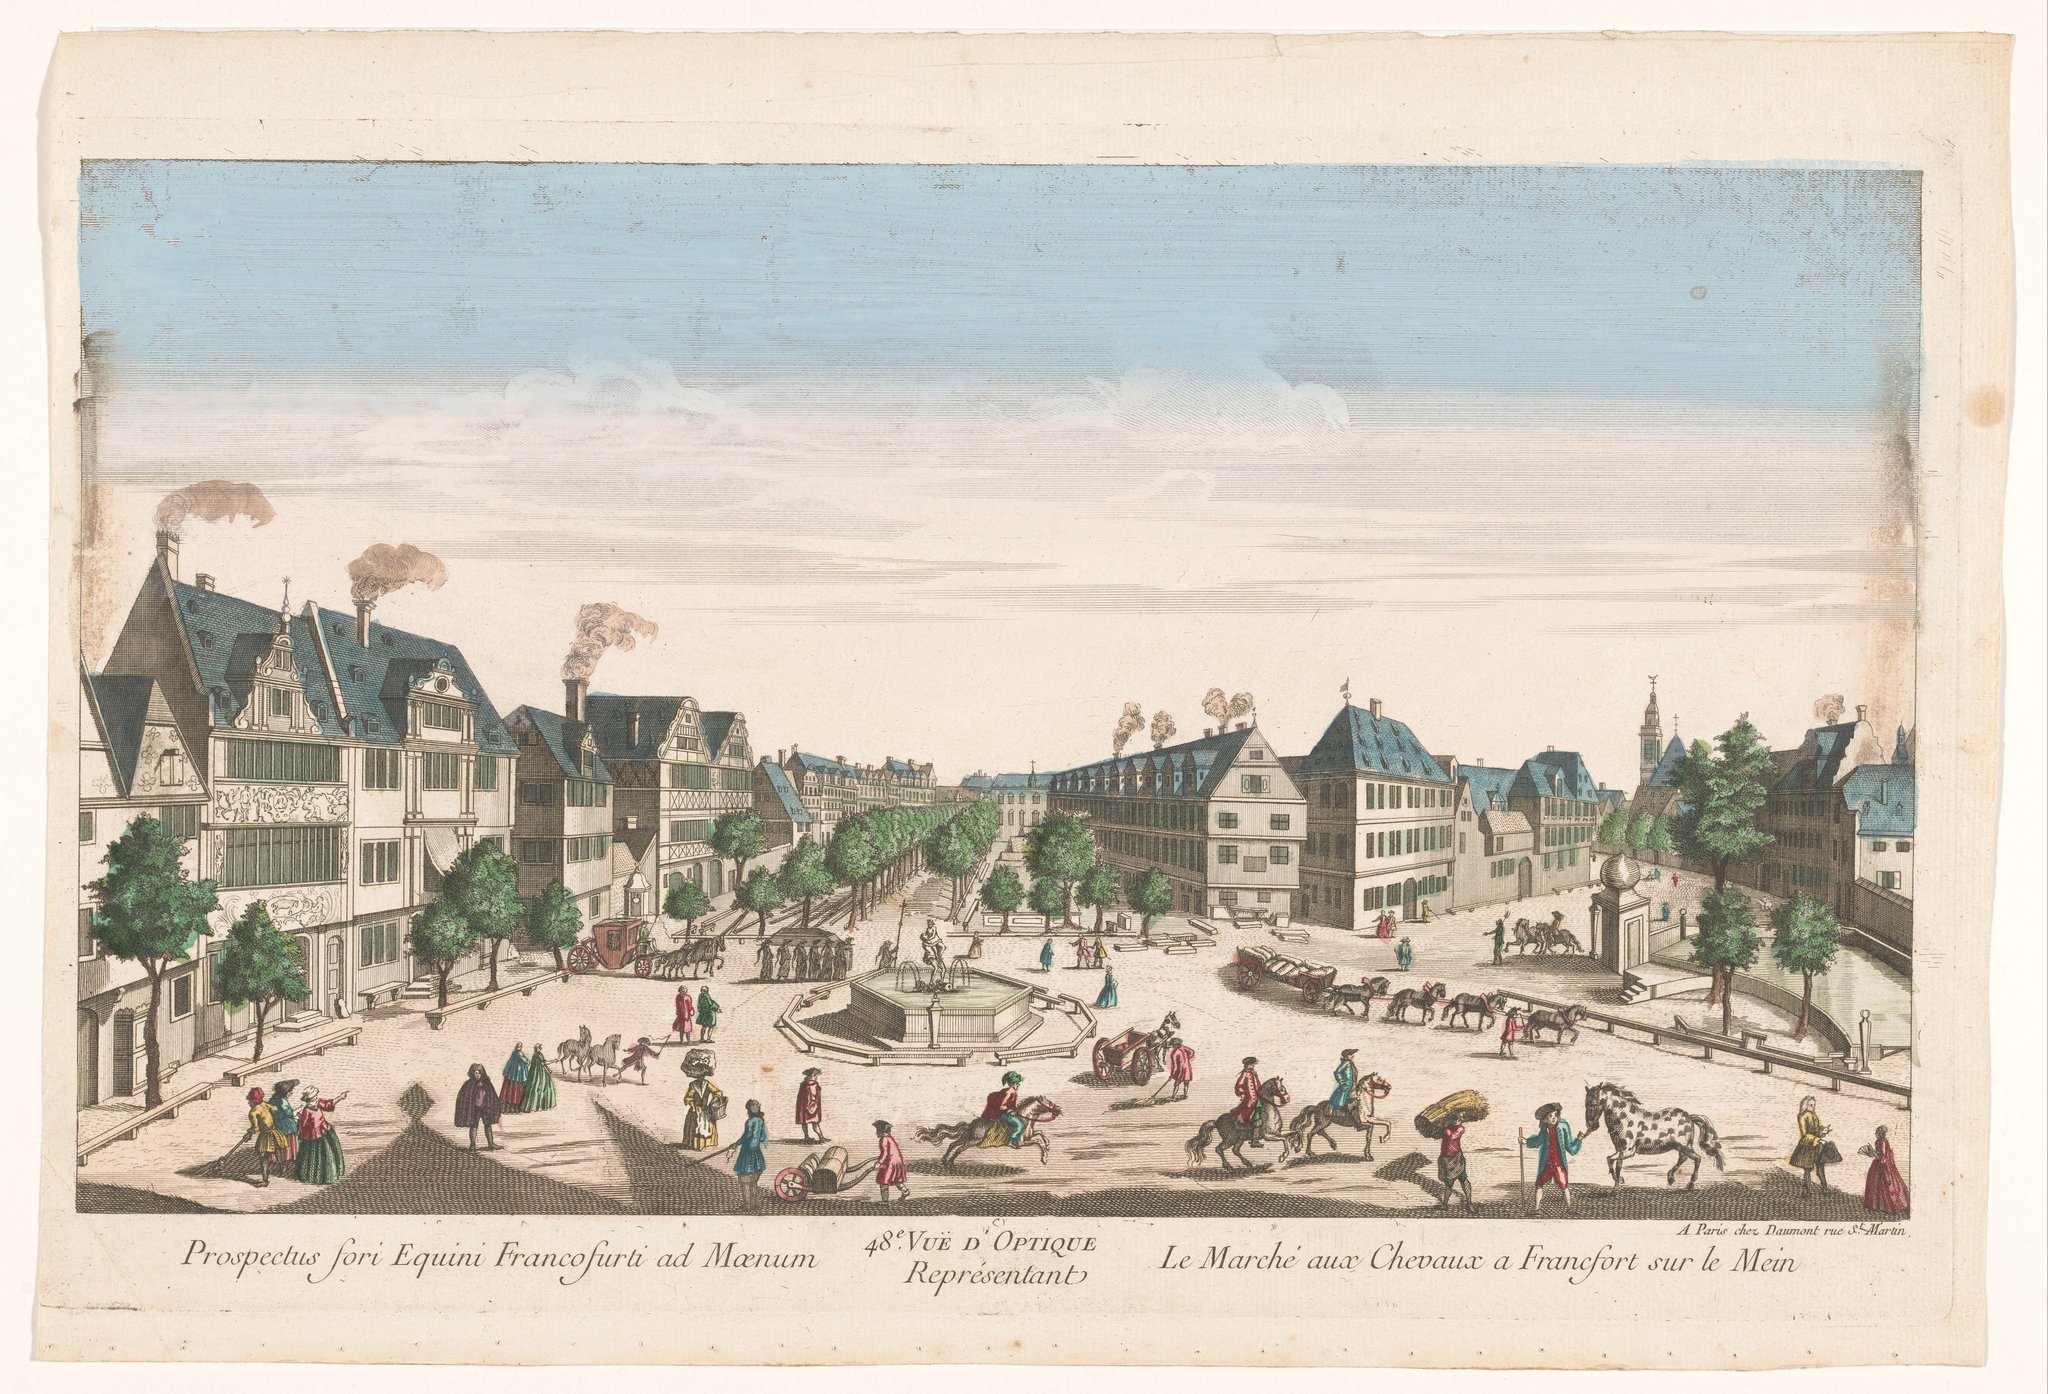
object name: print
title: 48e. Vuë d'optique représentant le Marché aux Chevaux a Francfort sur le Mein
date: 1745-1775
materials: paper, watercolor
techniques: brush, etching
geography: france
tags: avenue, boulevard, promenade, esplanade (+ city(-scape) with figures, staffage), church (exterior), square, place, circus, etc. (+ city(-scape) with figures, staffage)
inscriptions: collector's mark: Lugt 2166, watermark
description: In het midden een laan met kastanjebomen en rechts de St.-Katharinen-Kirche. In de titel genummerd: 48.